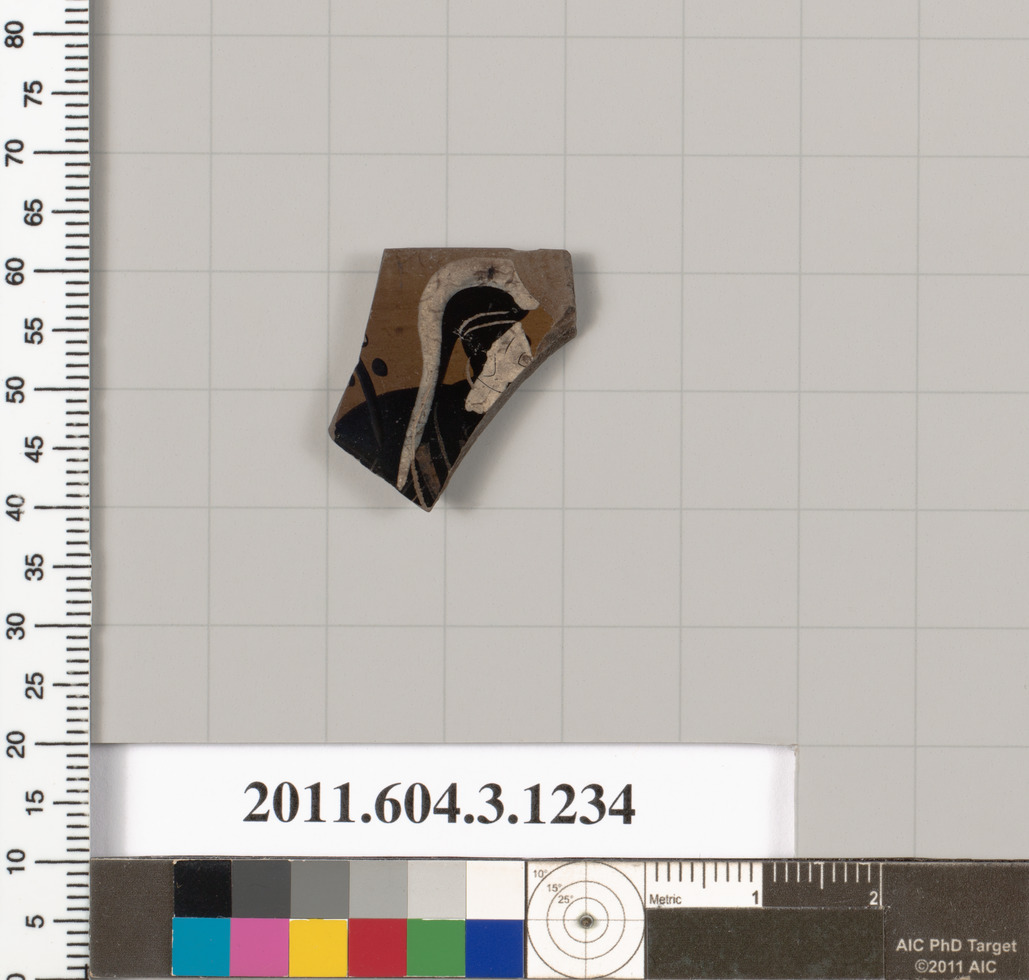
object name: kyathos fragment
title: Terracotta rim fragment of a kyathos (cup-shaped ladle)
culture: greek, attic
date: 534-468 BCE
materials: terracotta